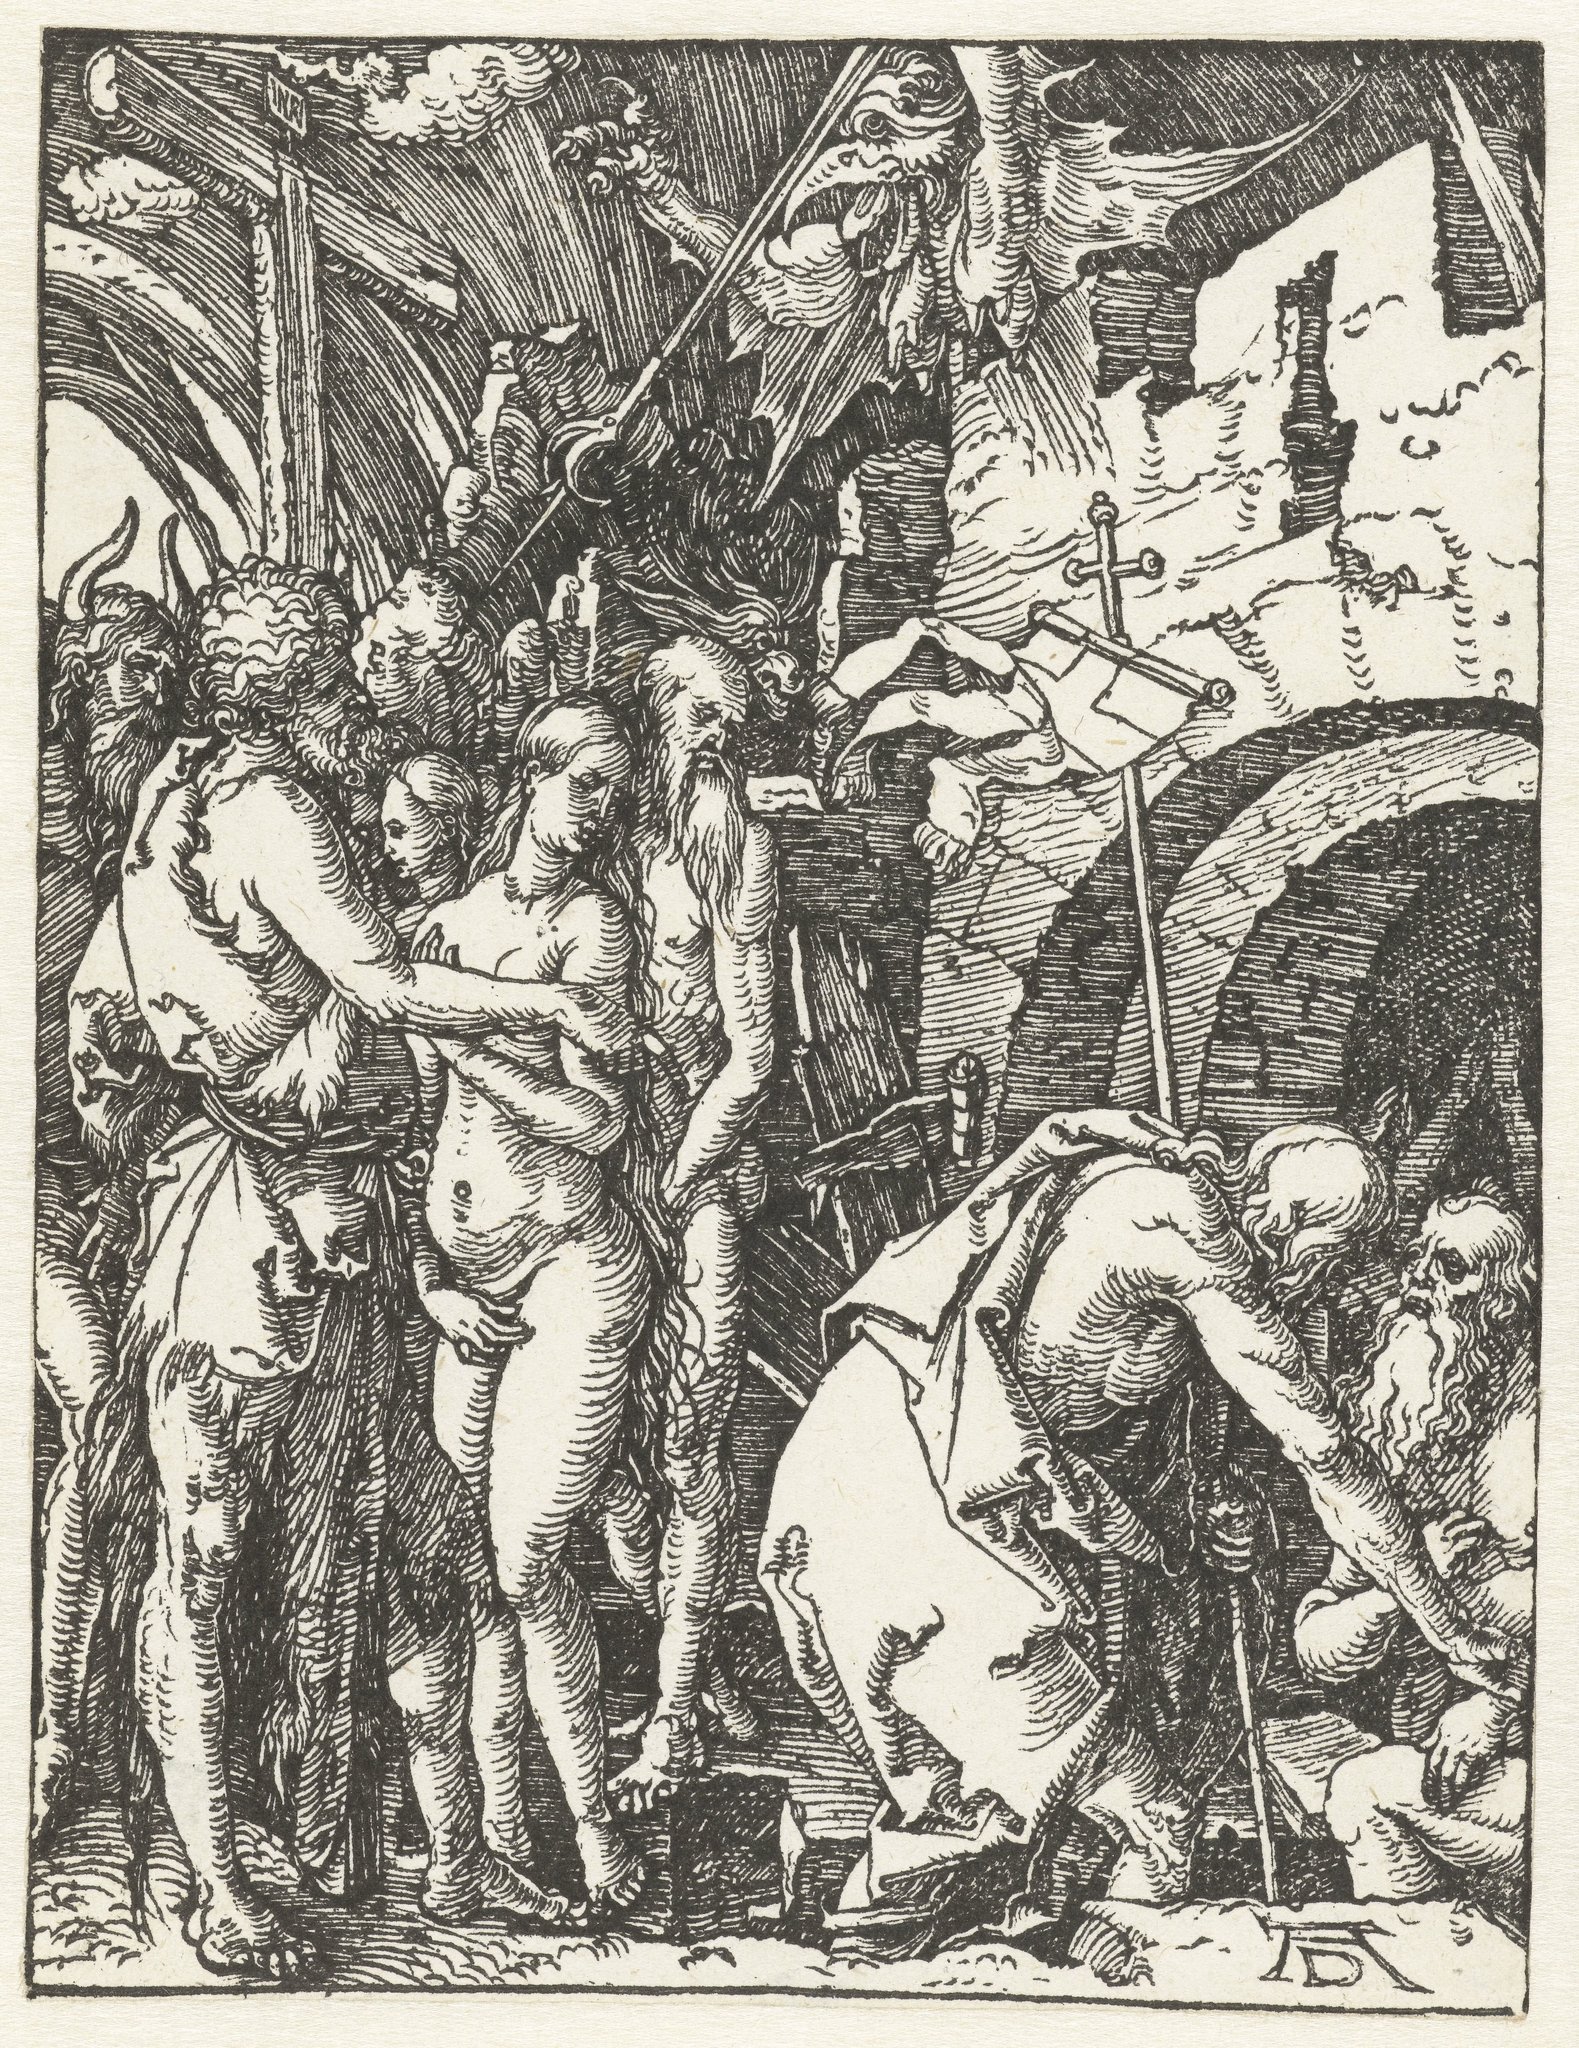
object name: print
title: Afdaling in het voorgeborchte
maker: albrecht dürer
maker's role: draughtsman, painter, print maker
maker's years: 1471-1528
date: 1509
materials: paper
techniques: woodcut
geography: nuremberg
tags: christ leaving hell: he liberates patriarchs, prophets, kings and other persons from hell, among them adam, eve, moses, david, and john the baptist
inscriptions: collector's mark: Lugt 2228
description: Christus bevrijdt zielen uit het voorgeborchte. Deze prent is onderdeel van de prentserie 'De kleine Passie', bestaande uit een titelprent en 36 bijbelse scènes (voornamelijk uit het Lijdensverhaal).